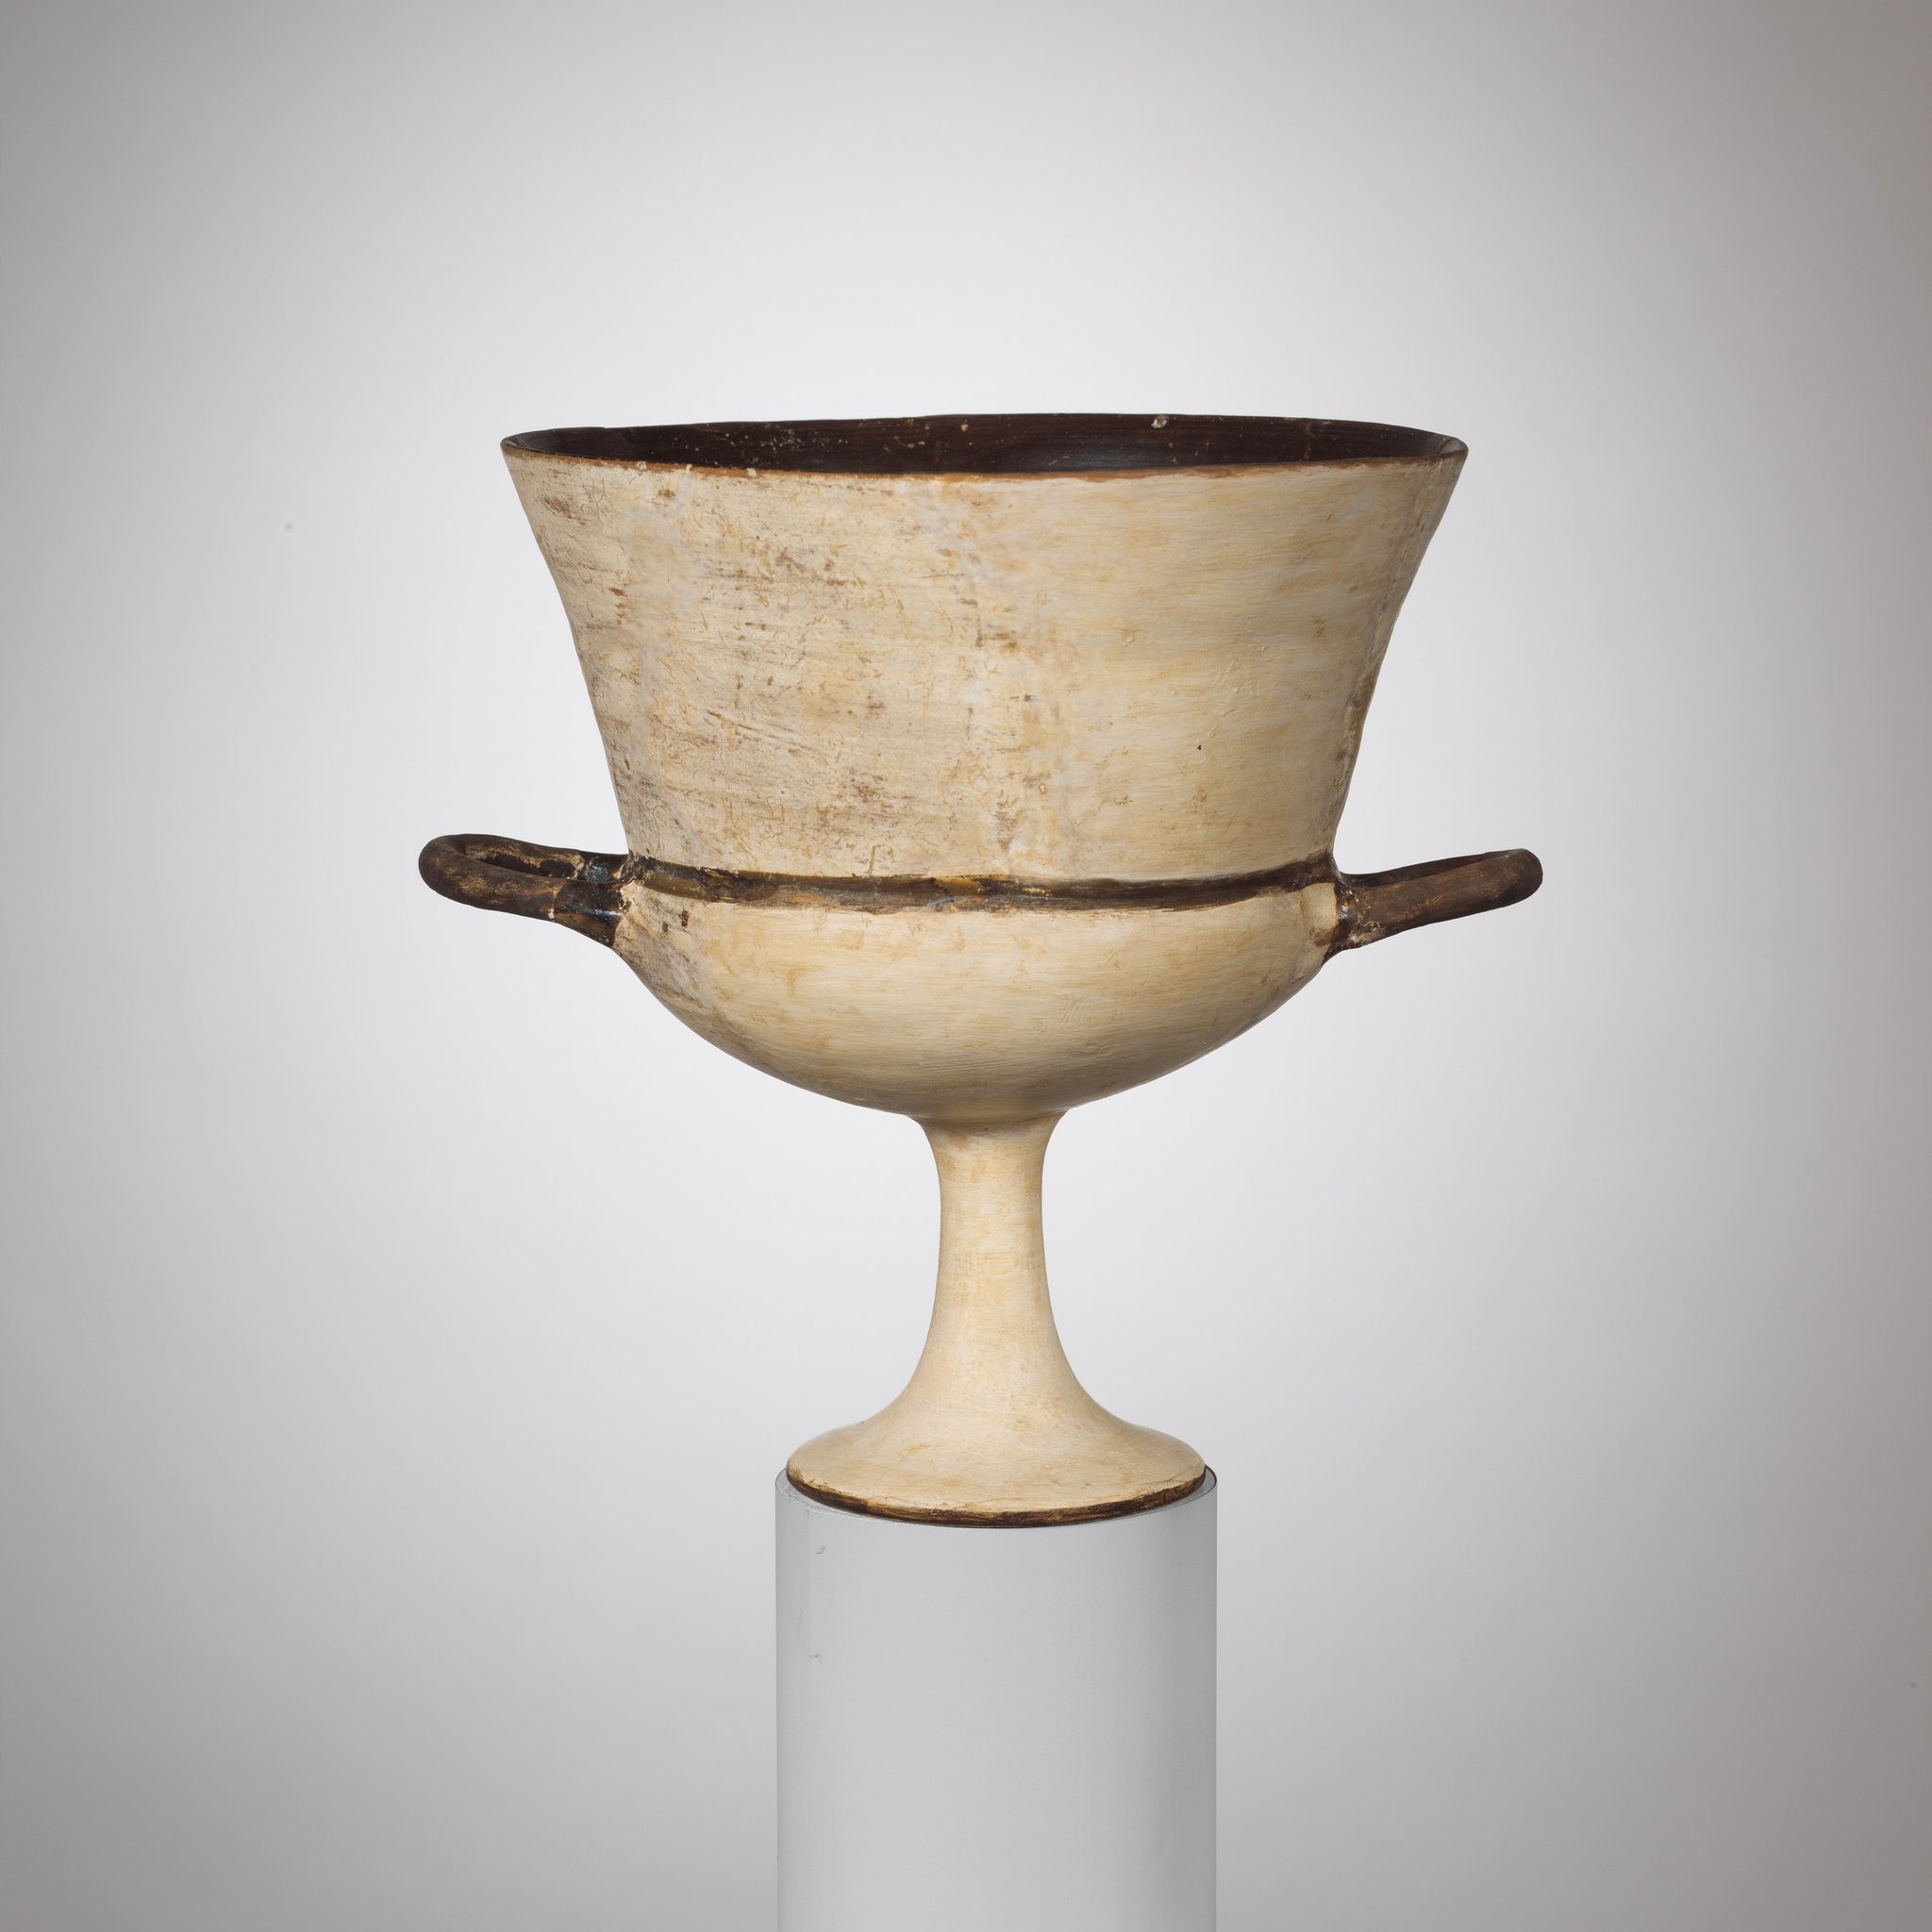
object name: cup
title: Terracotta cup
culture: greek or lydian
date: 600-501 BCE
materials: terracotta